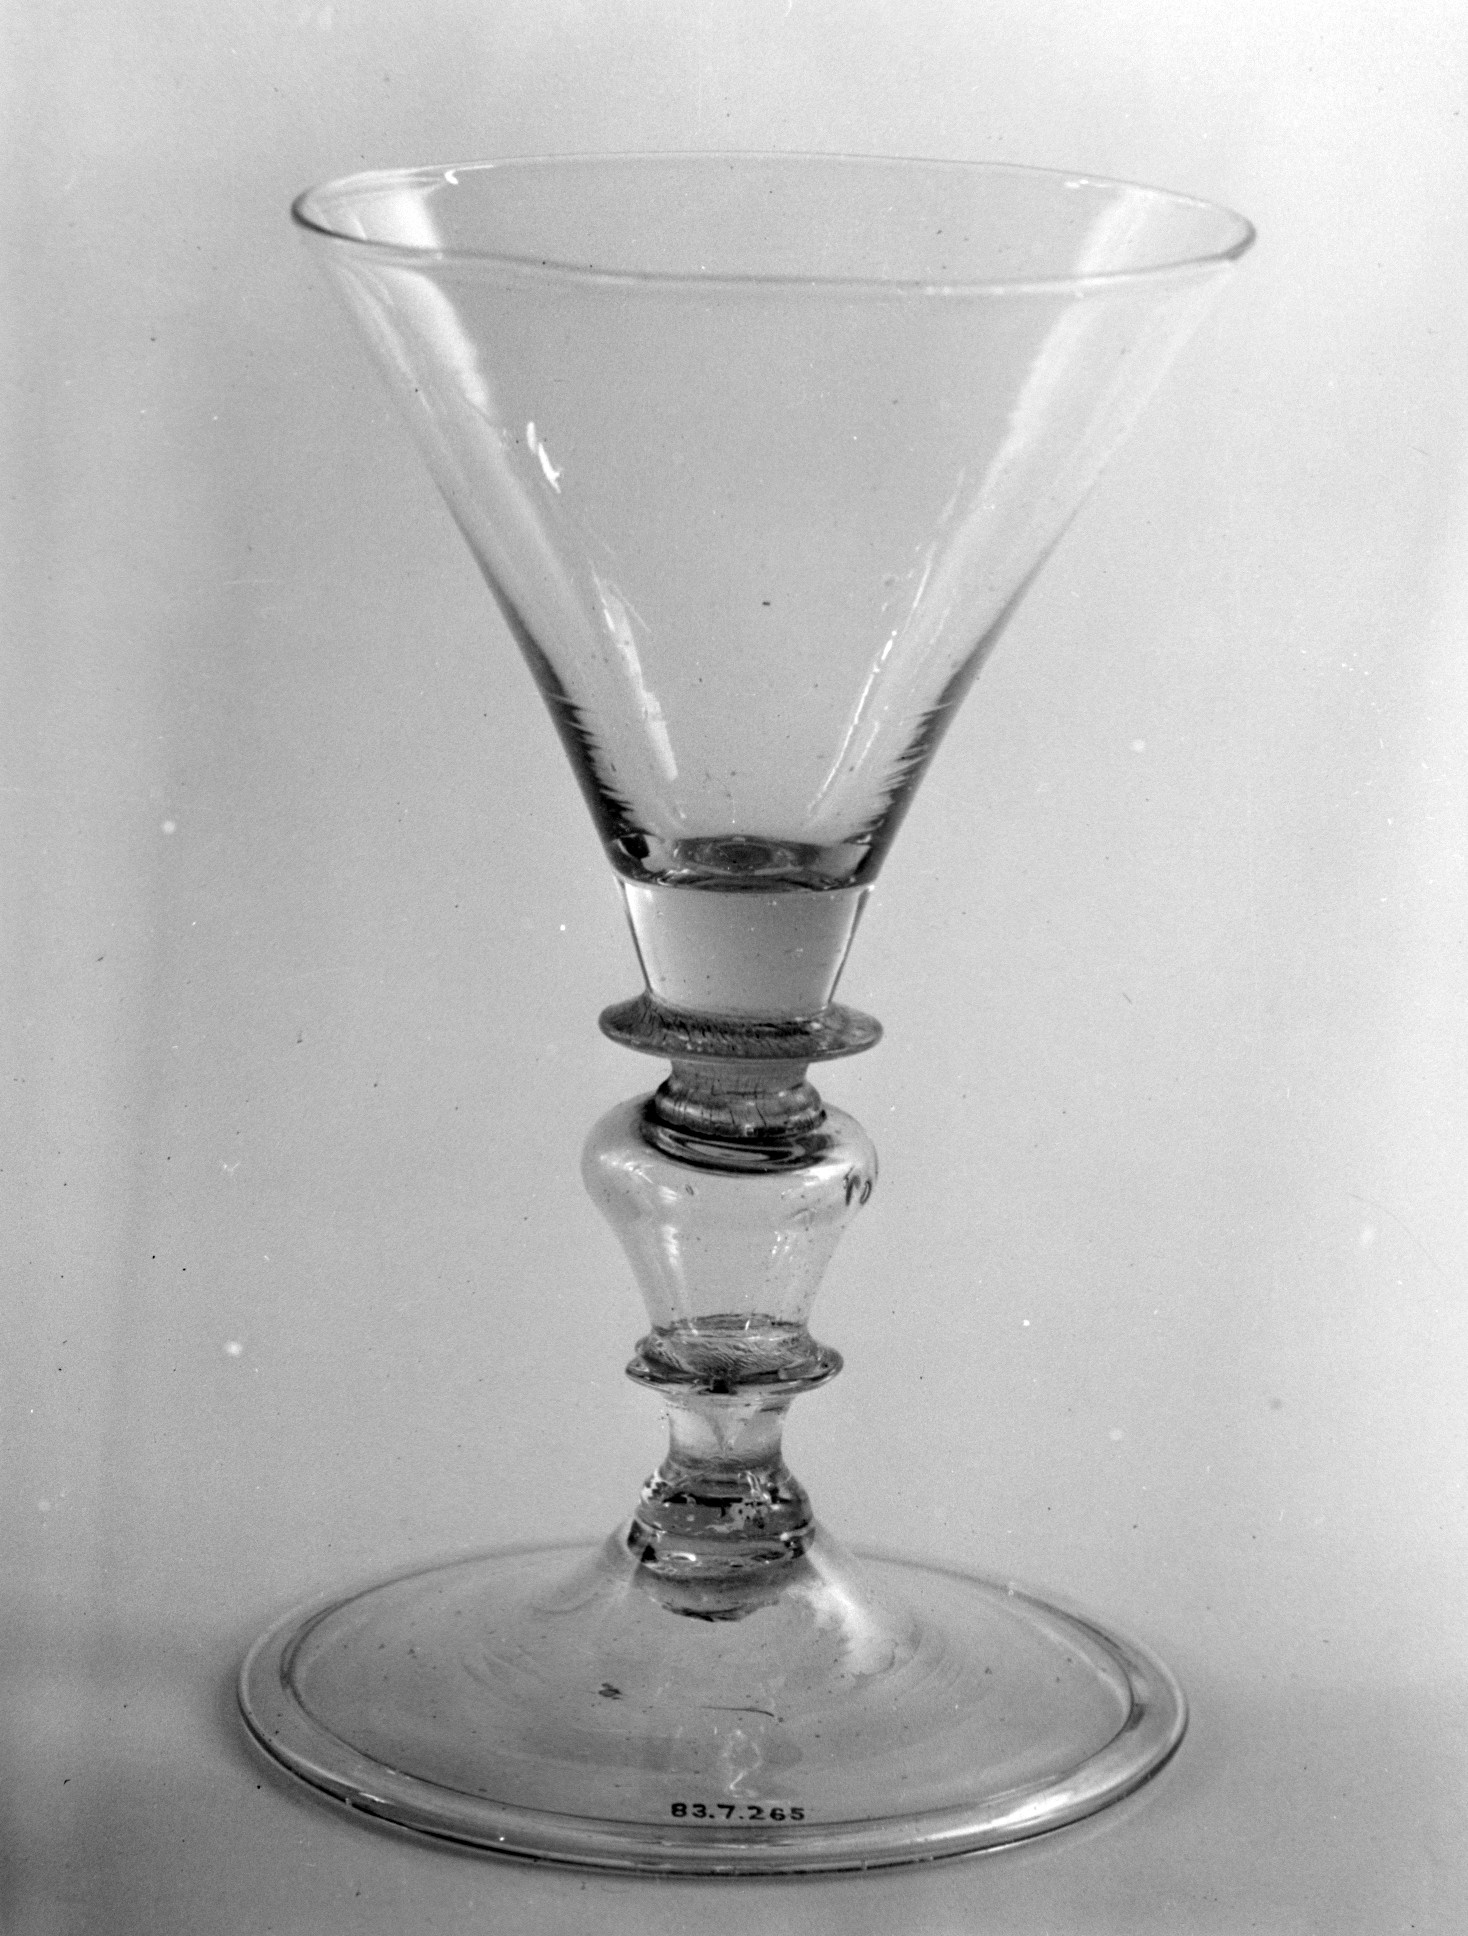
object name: wineglass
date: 1700-1750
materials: glass